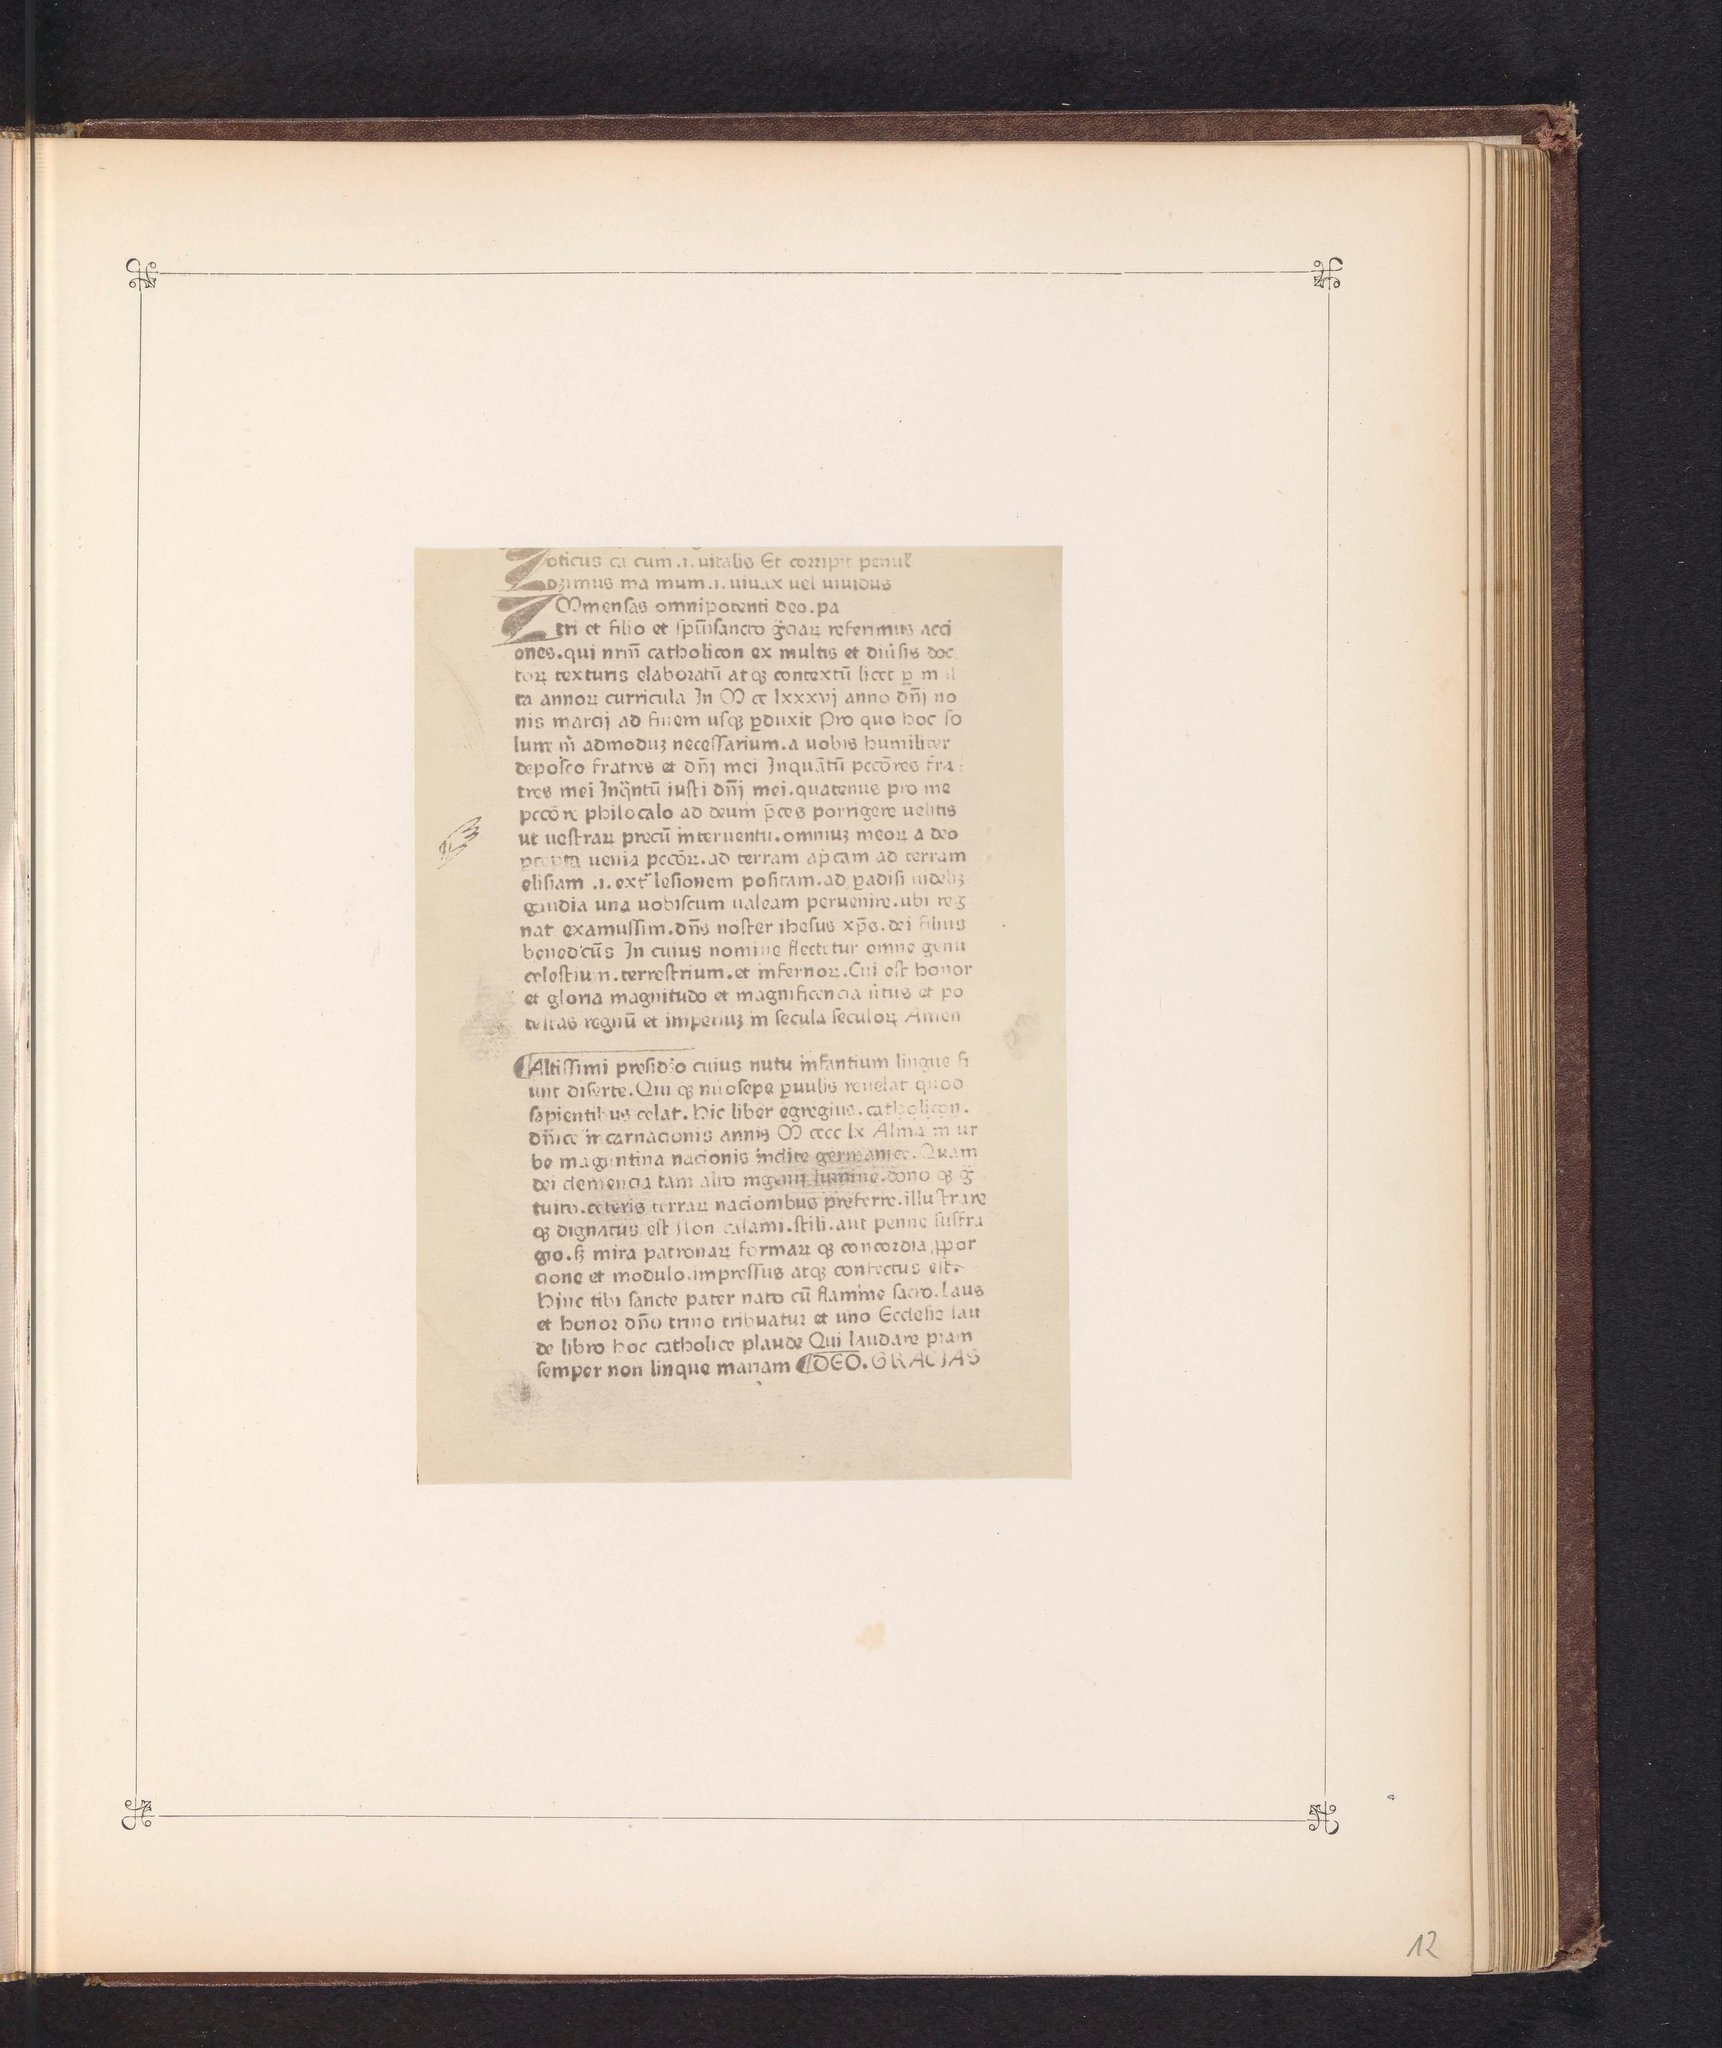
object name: page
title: Fotoreproductie van de laatste pagina van de Catholicon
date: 1867-1872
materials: photographic support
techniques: albumen print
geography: mainz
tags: book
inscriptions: number: ‘12’